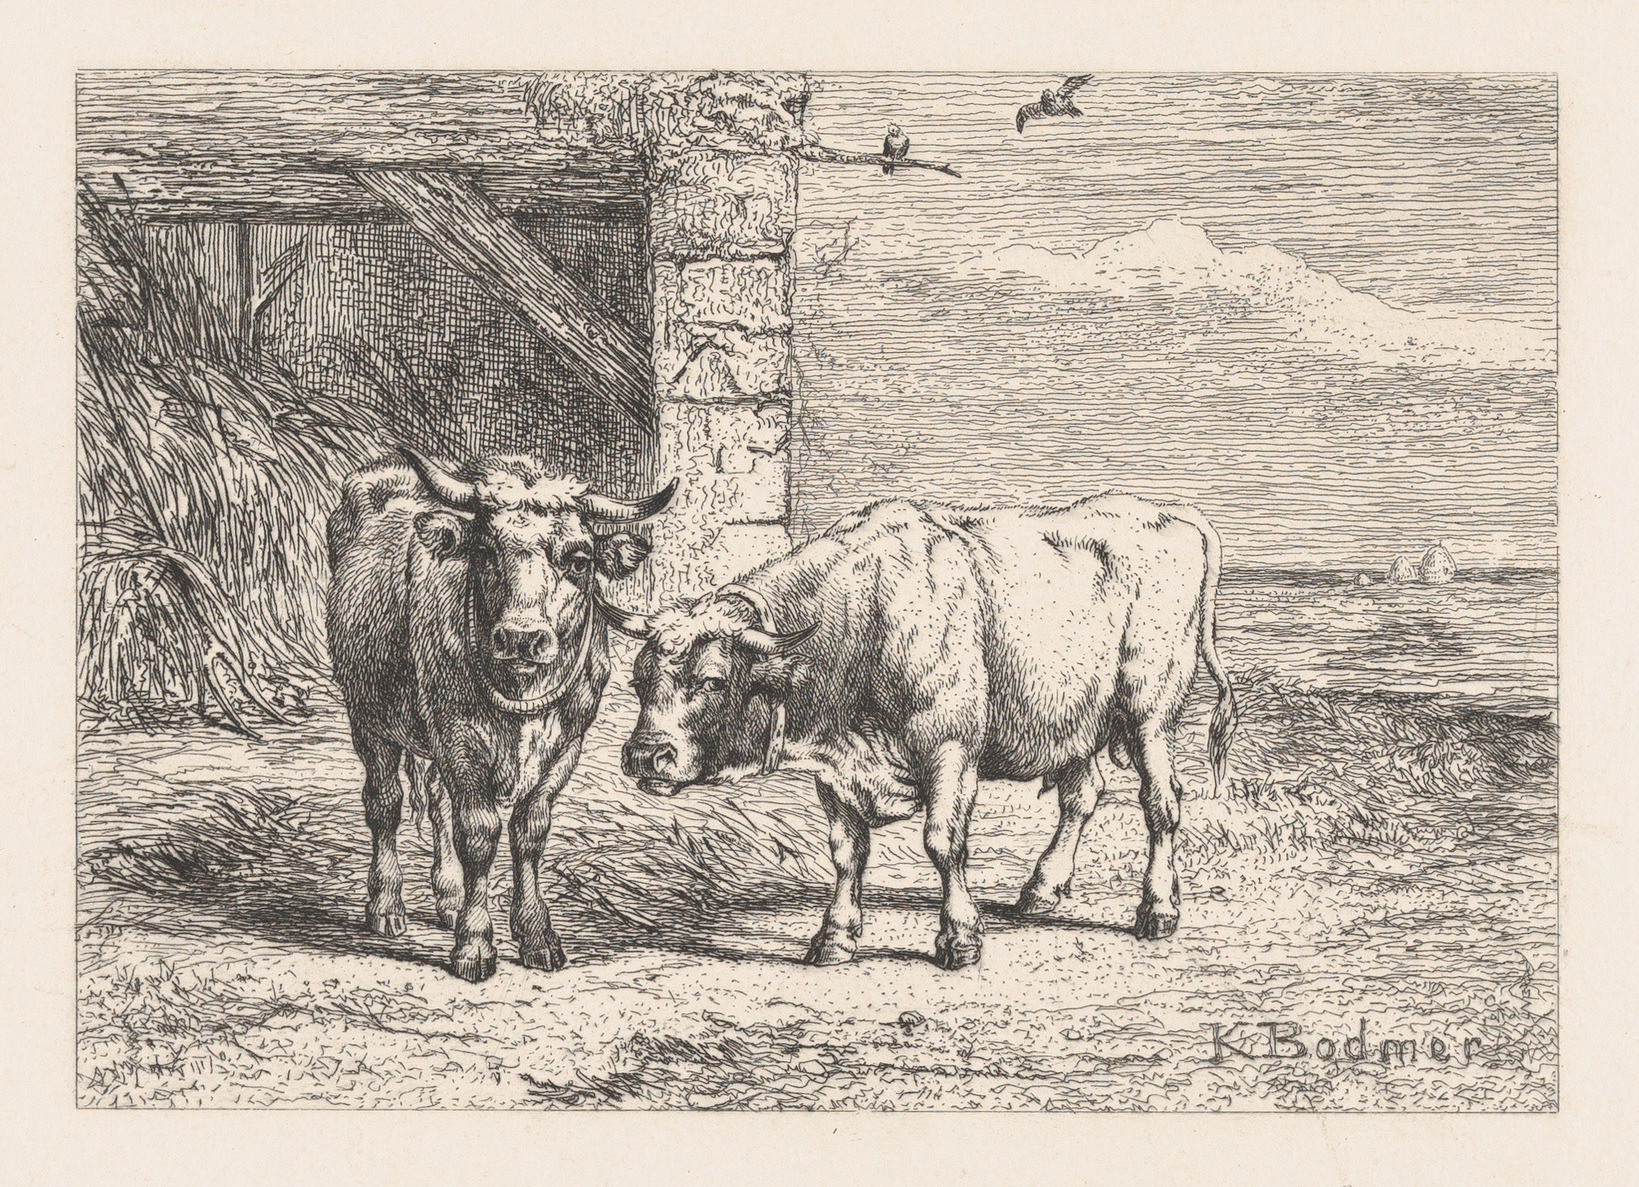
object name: print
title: Bulls, from "Eaux-Fortes Animaux & Paysages"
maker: karl bodmer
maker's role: artist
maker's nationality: swiss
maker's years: 1809-1893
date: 1860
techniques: etching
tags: bulls